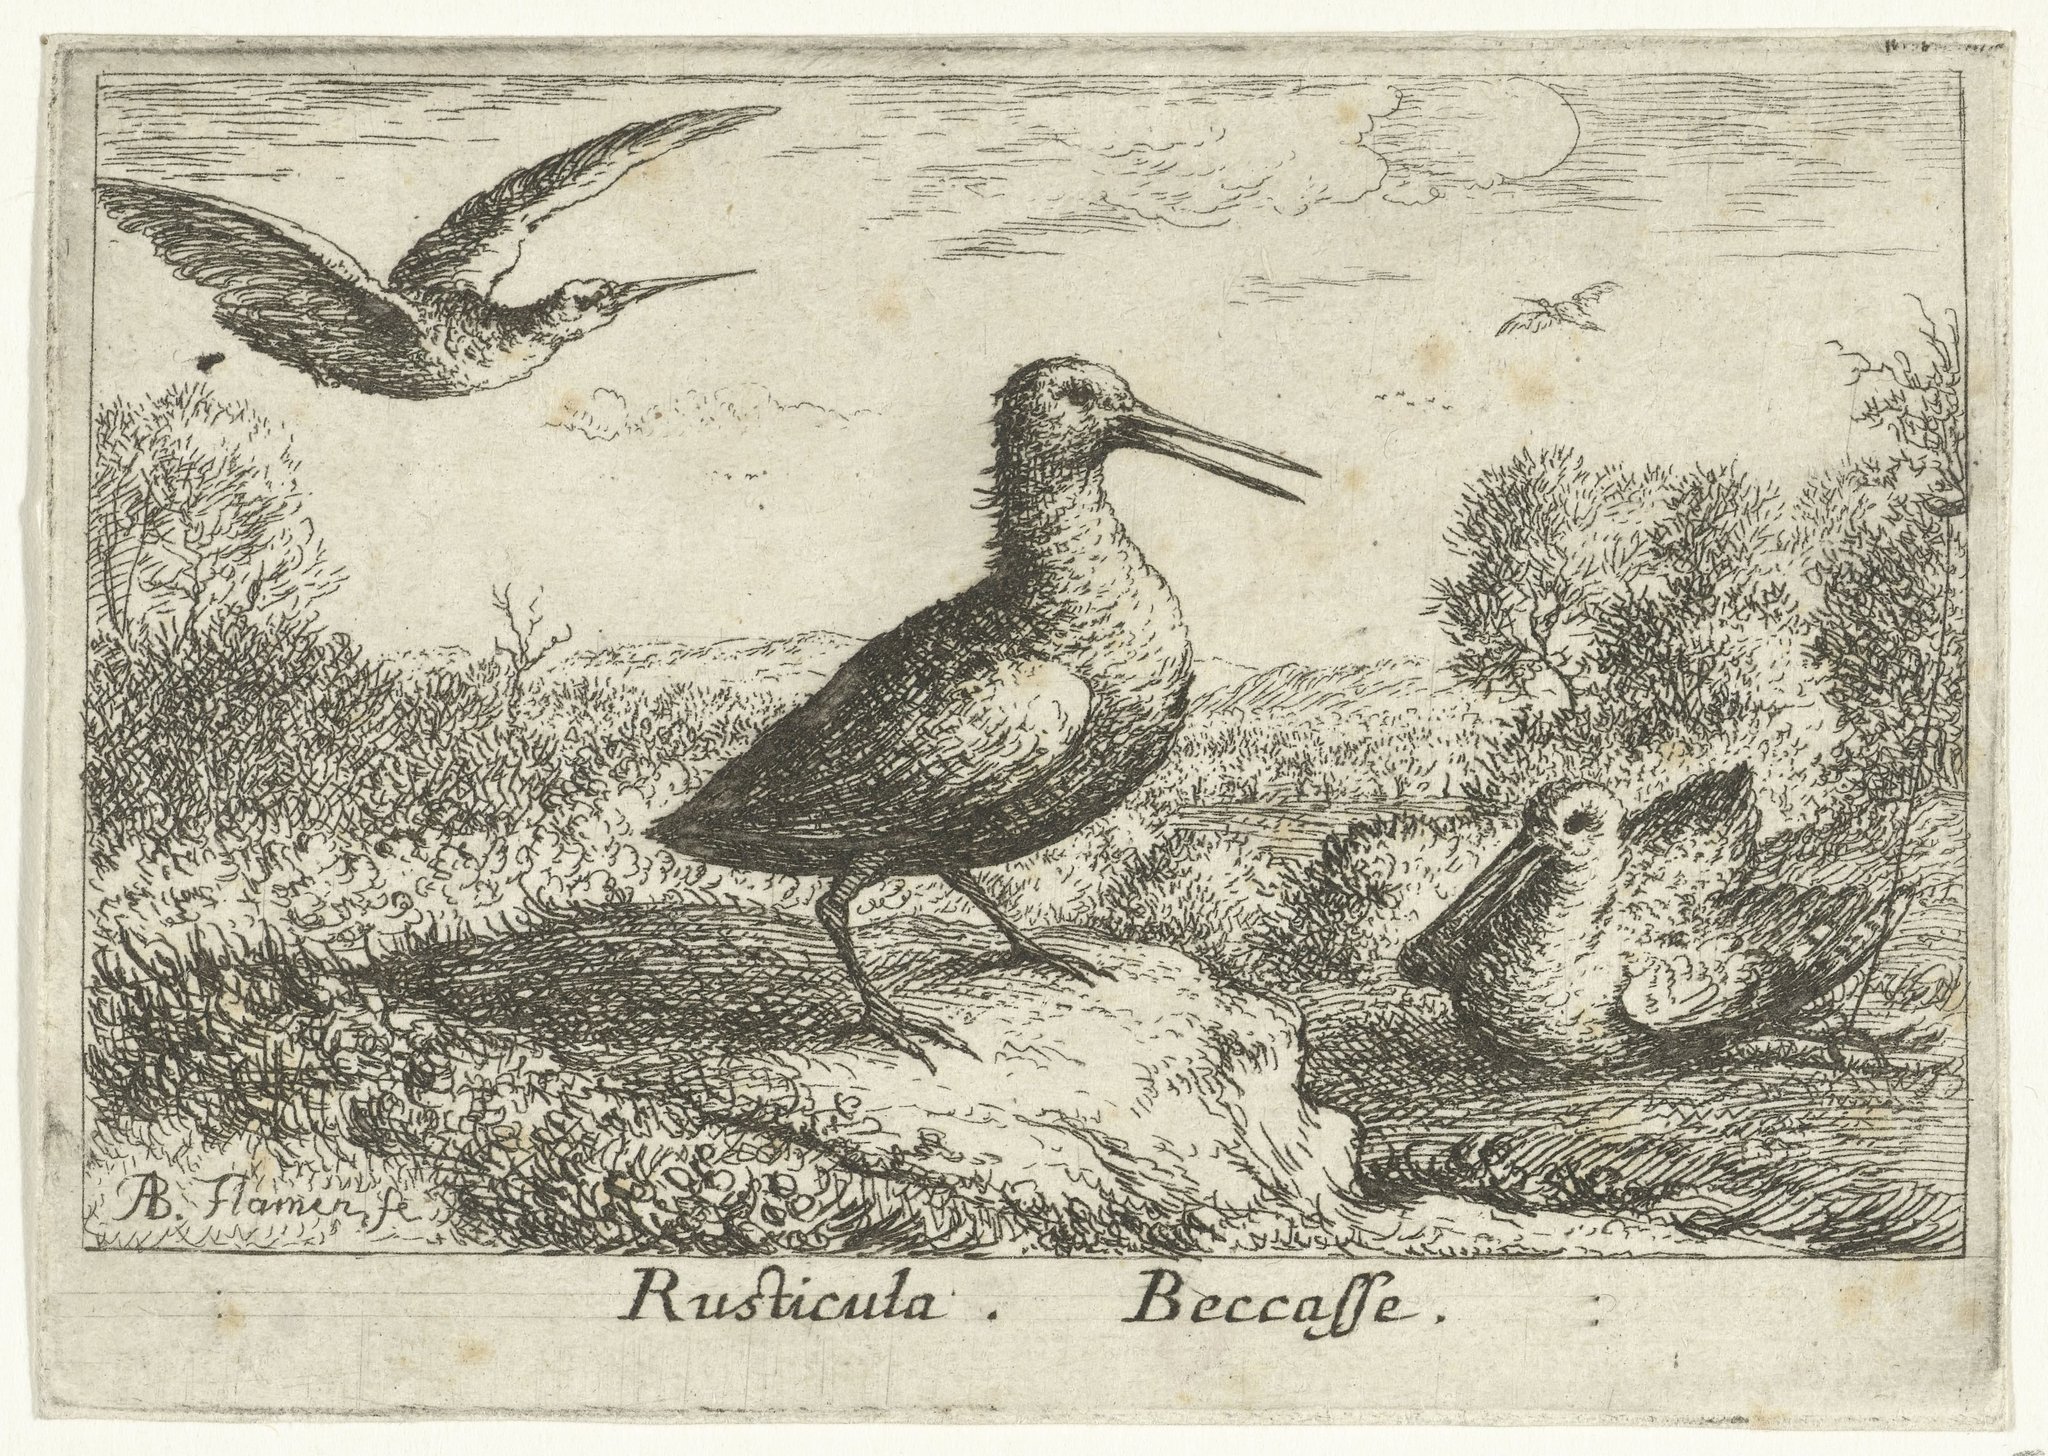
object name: print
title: Landschap met drie snippen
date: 1659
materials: paper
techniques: etching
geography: paris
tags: shore-birds and wading-birds: woodcock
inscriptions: collector's mark: Lugt 2228